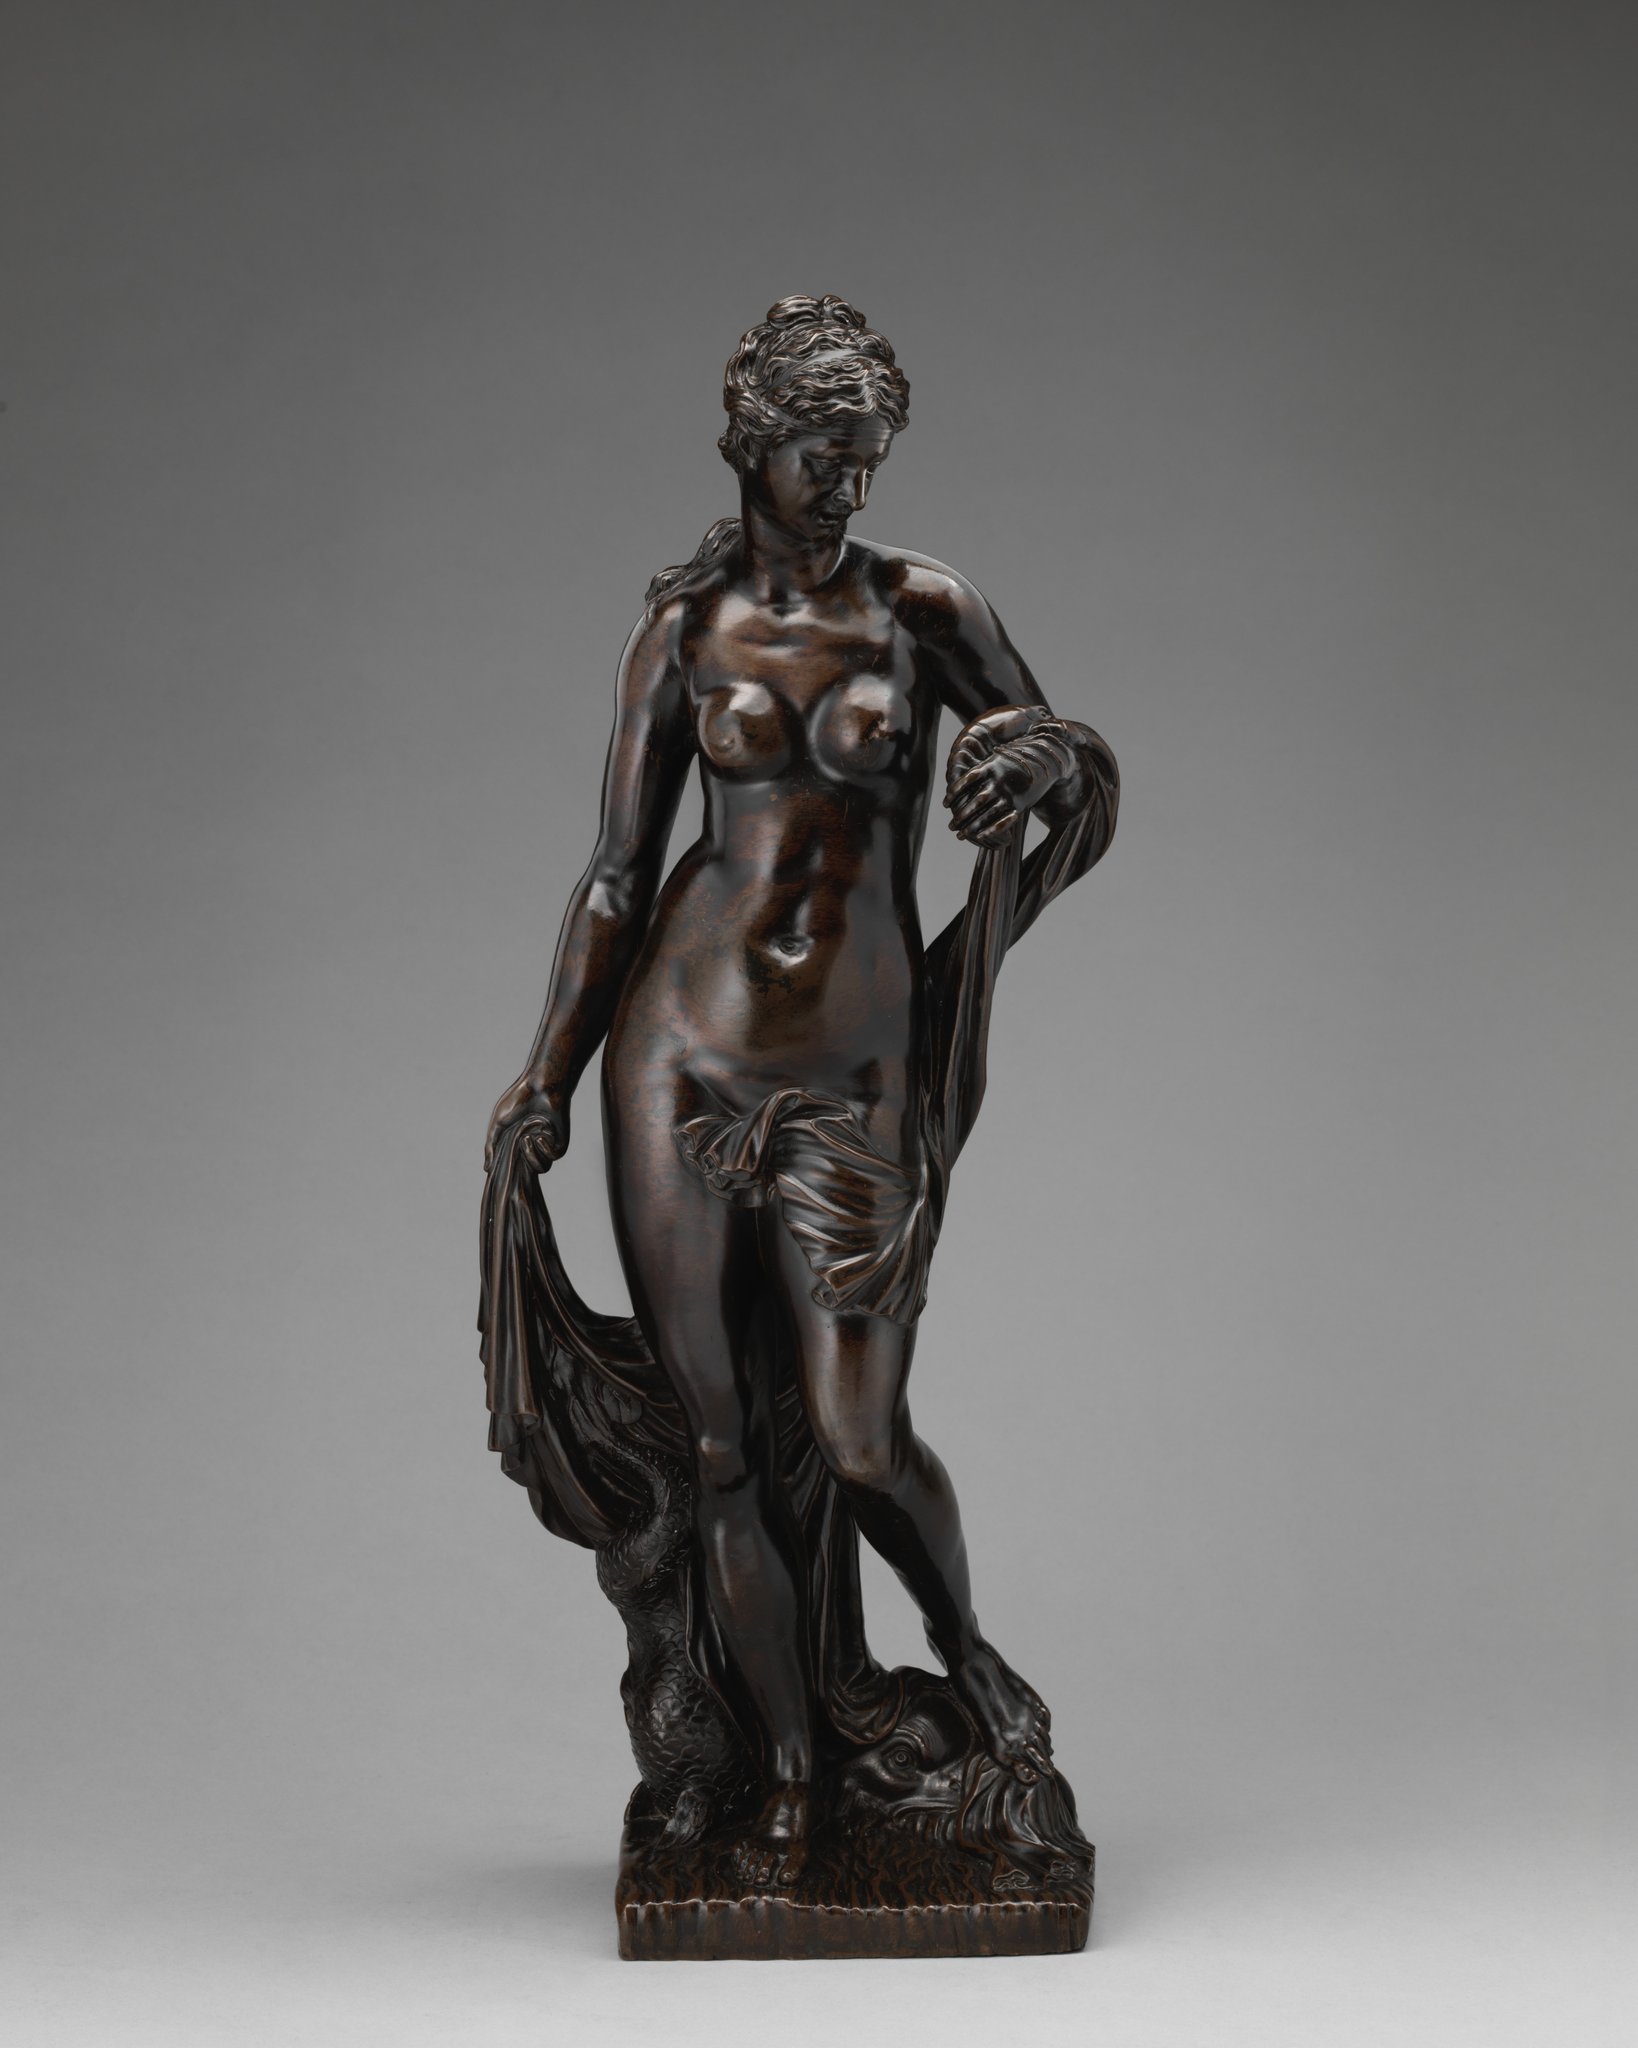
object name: statuette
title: Amphitrite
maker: michel anguier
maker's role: artist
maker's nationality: french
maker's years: 1612-1686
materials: bronze